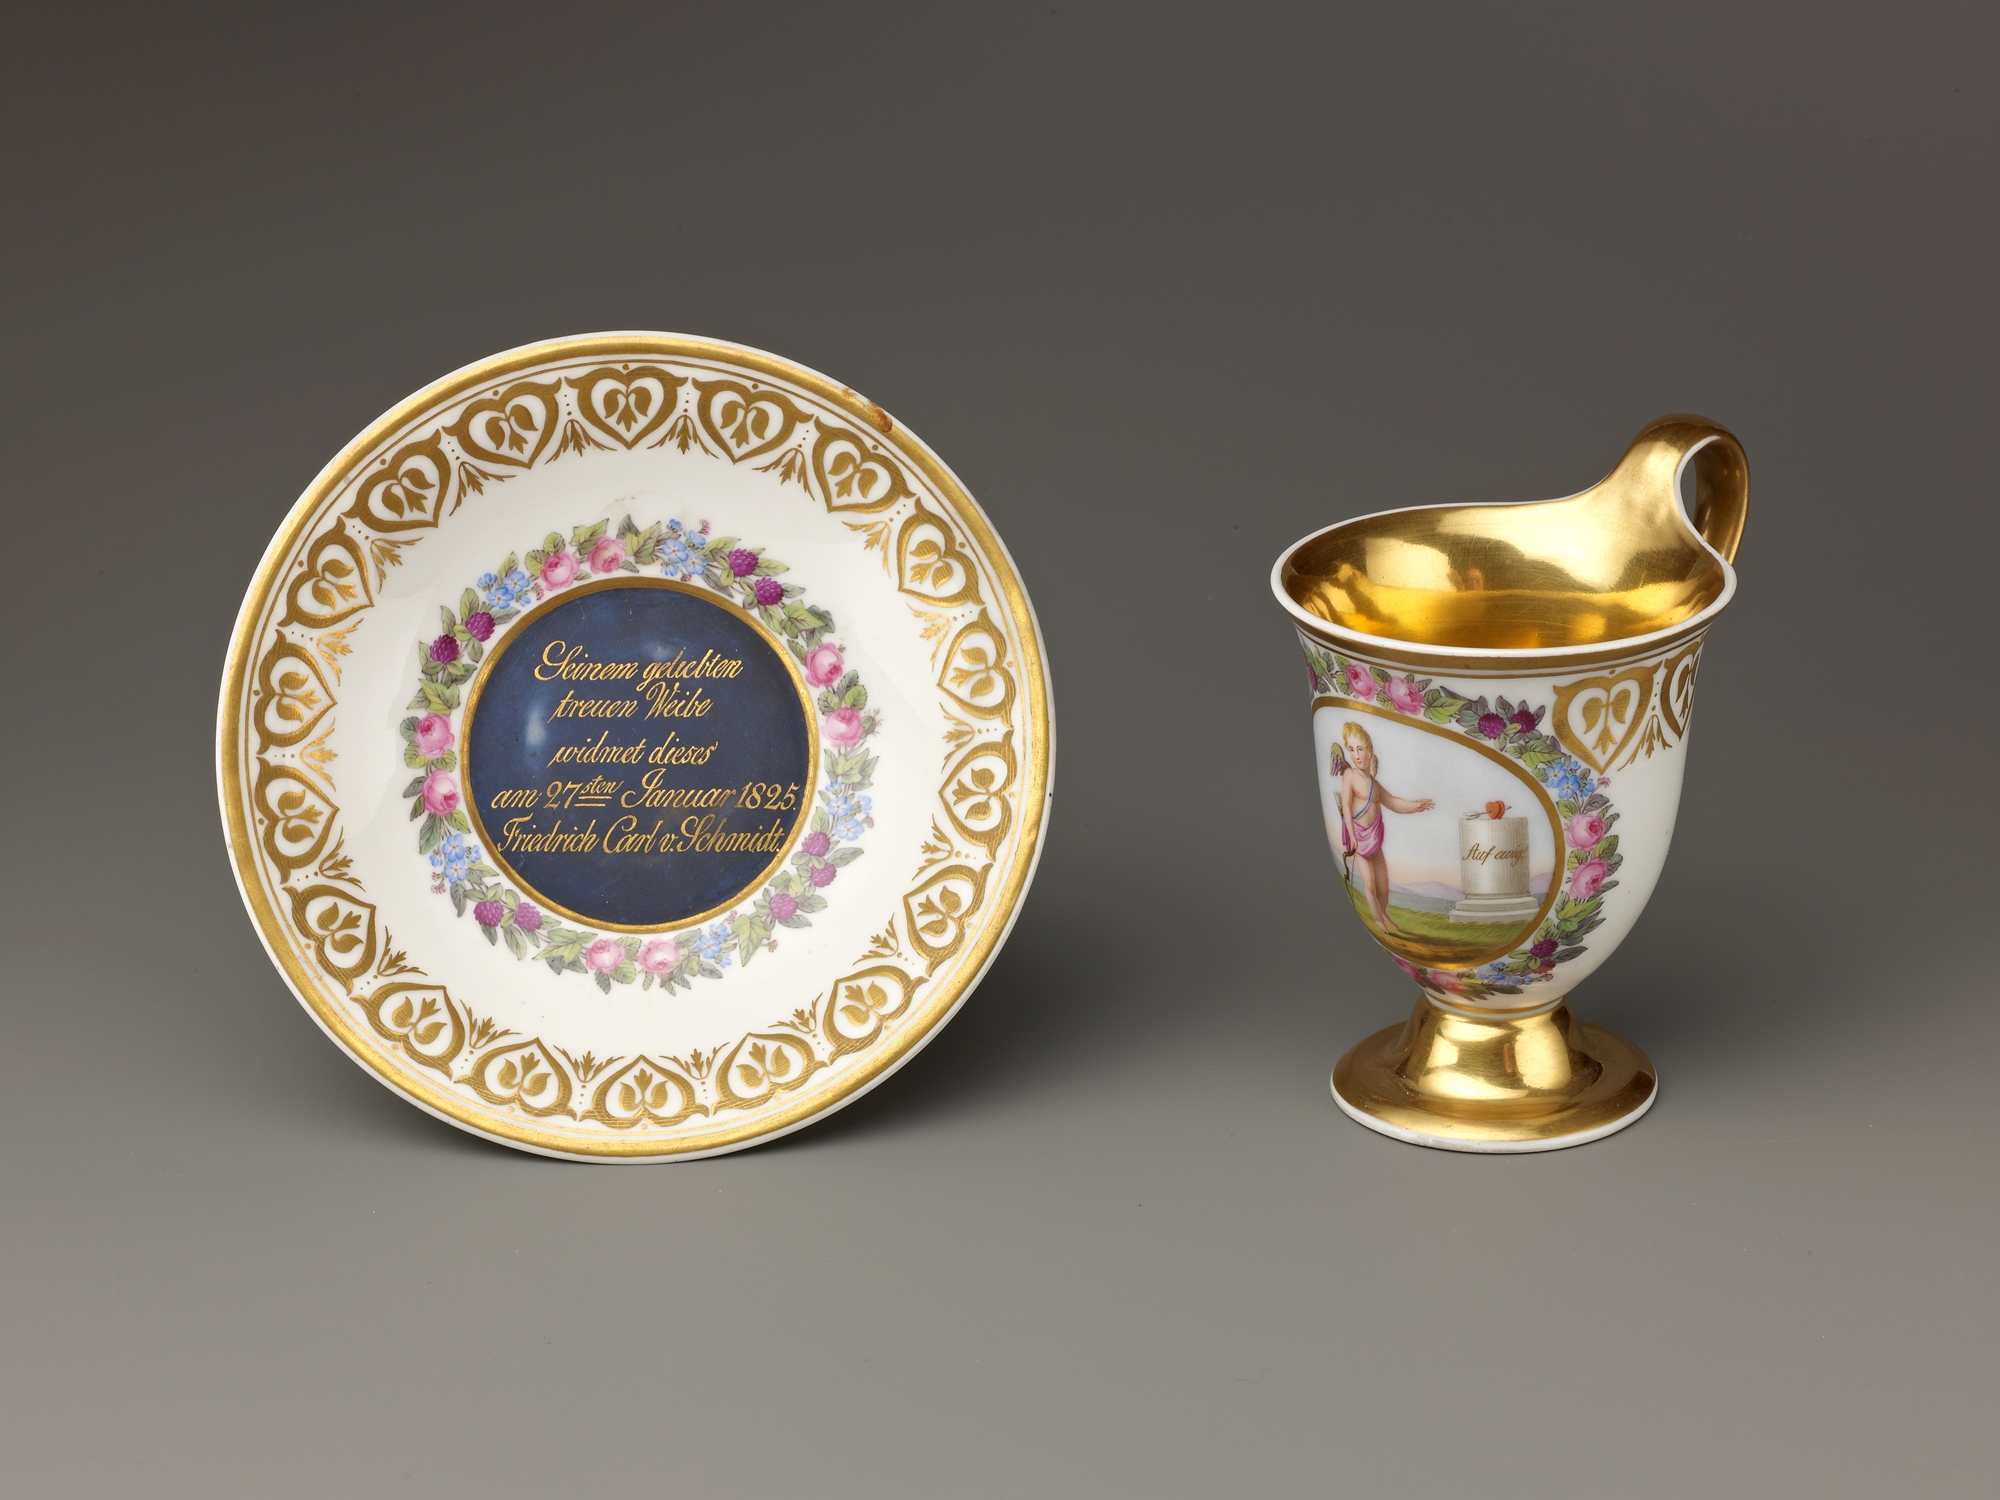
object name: cup and saucer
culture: german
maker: royal porcelain manufactory (königliche porzellan-manufaktur), berlin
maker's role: artist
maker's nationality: german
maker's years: 1763-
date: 1825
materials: hard paste porcelain